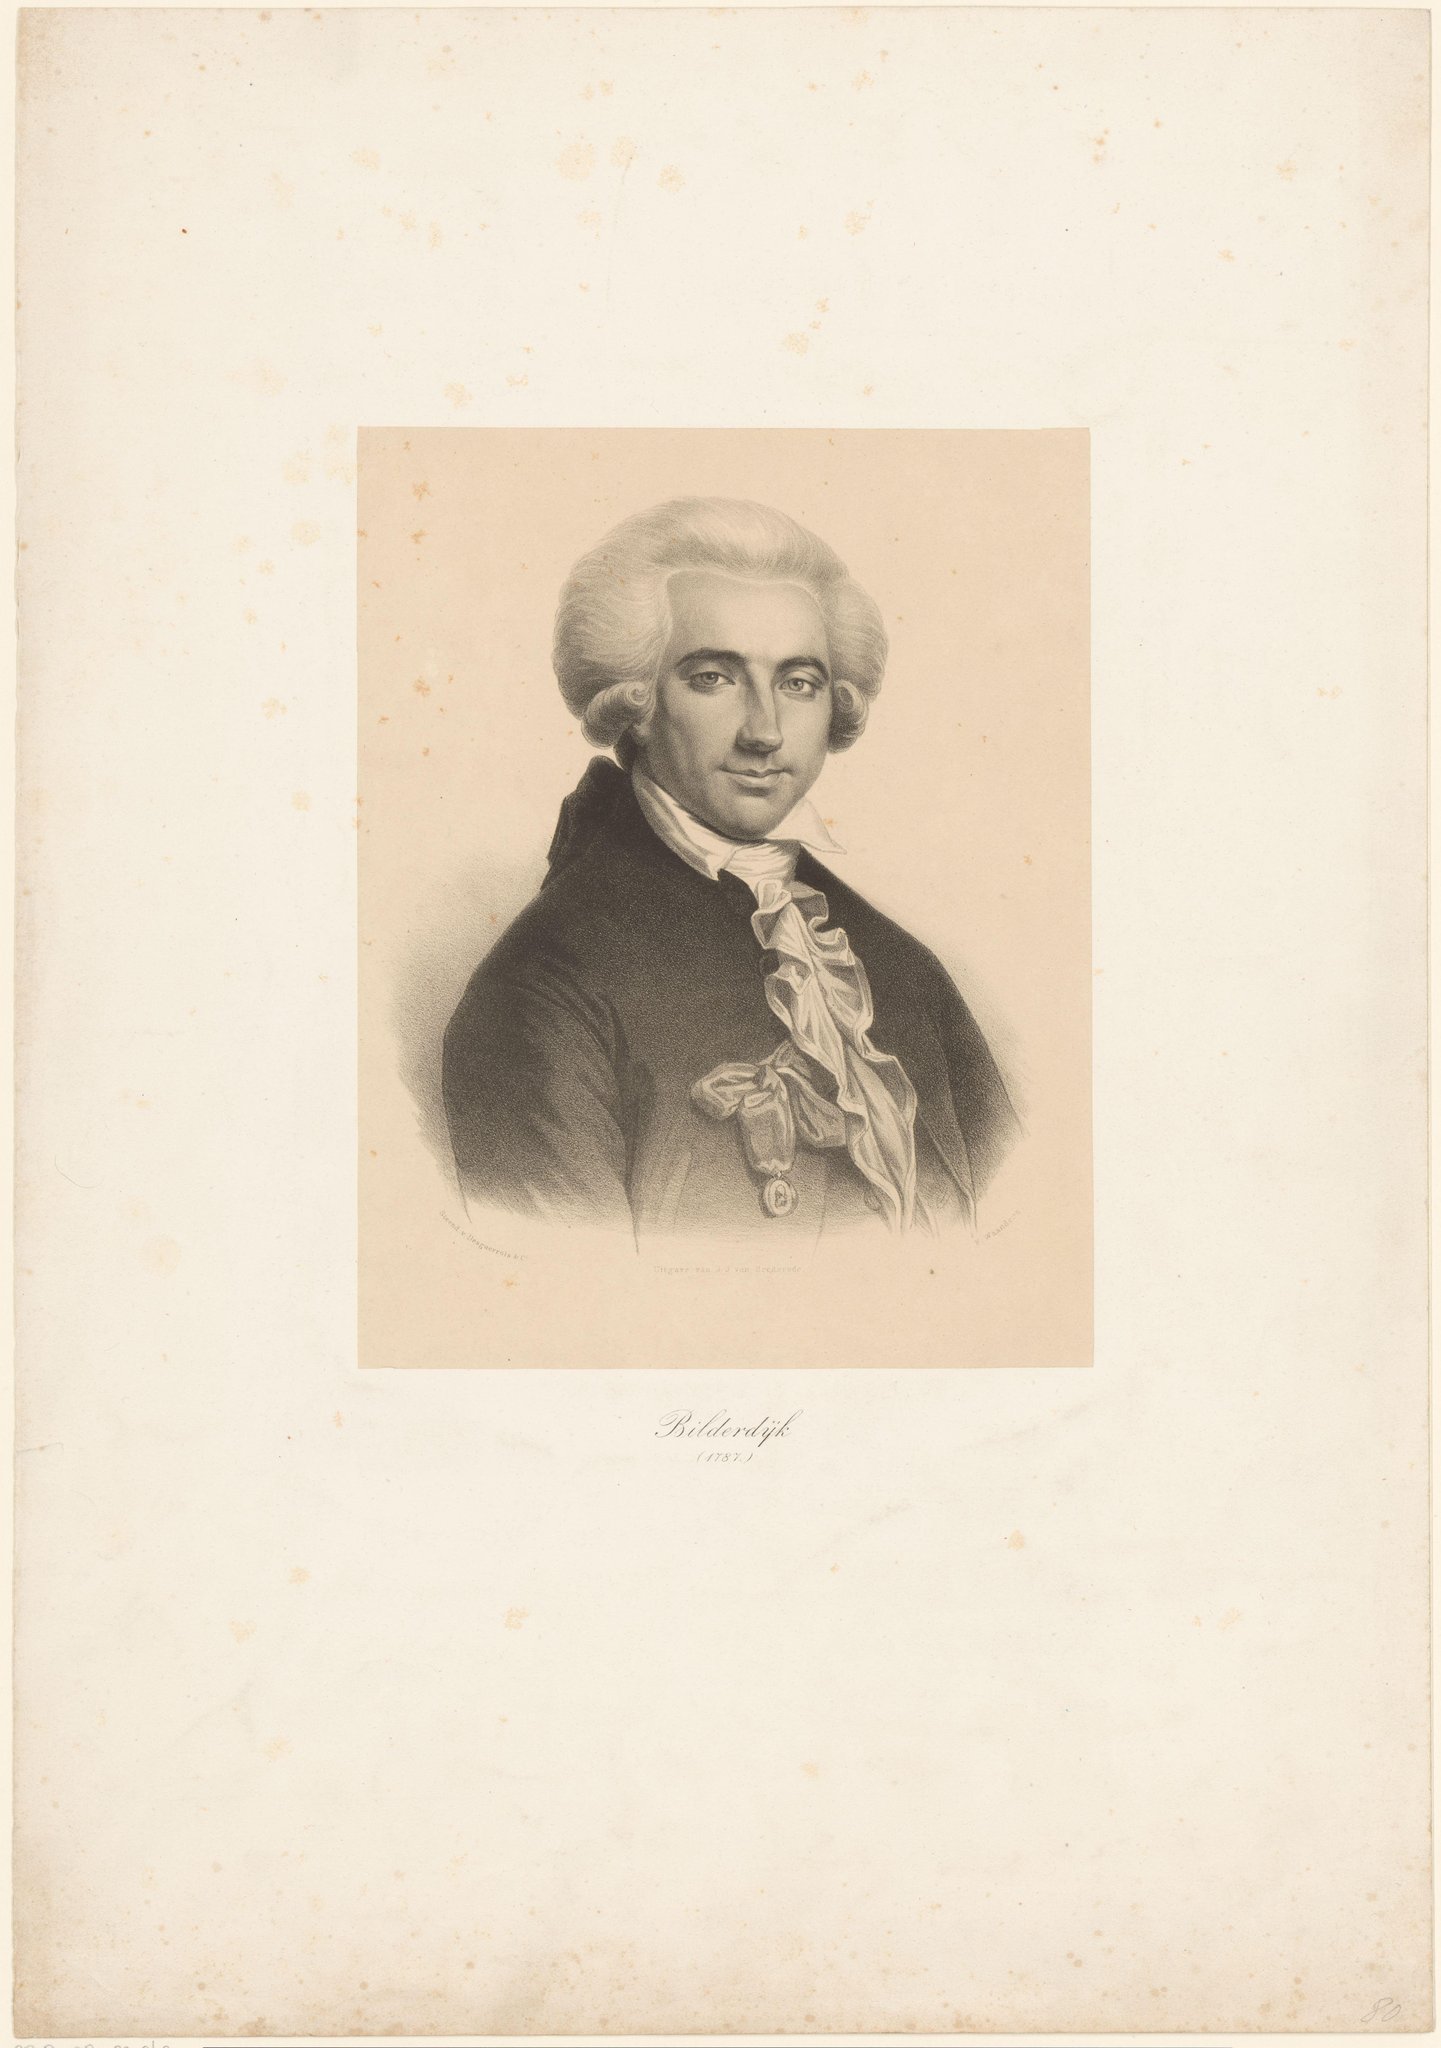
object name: book illustration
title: Bilderdijk (1787)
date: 1851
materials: paper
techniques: lithograph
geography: haarlem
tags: amsterdam, print maker, draughtsman, willem bilderdijk, historical persons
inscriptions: collector's mark: Lugt 2228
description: Prent uit: S.n. Album der schoone kunsten. Haarlem: Brederode, J.J. van, 1851.